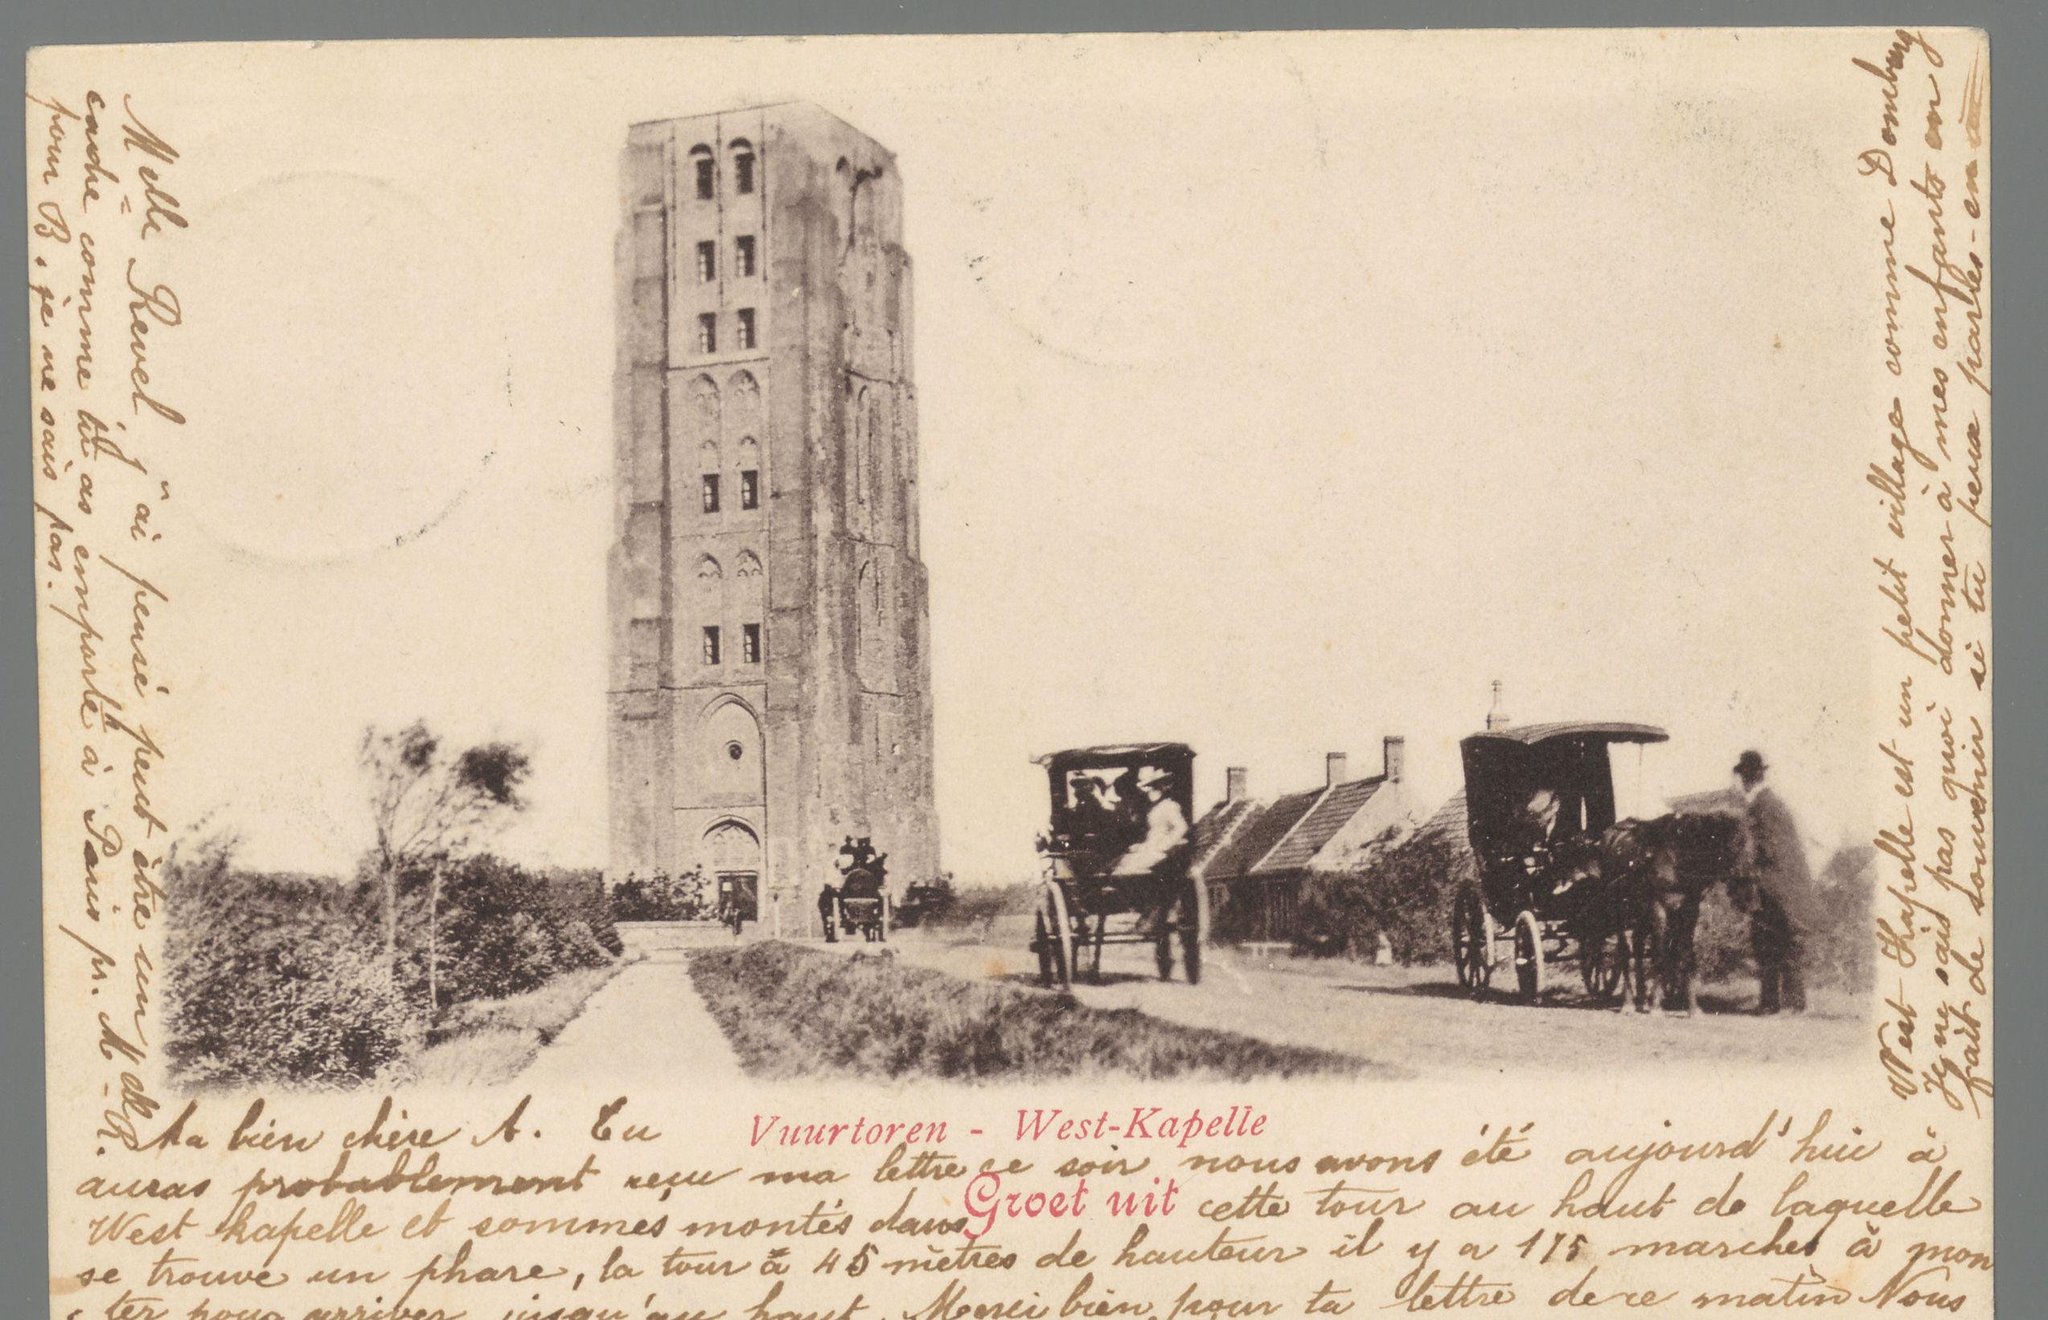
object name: photomechanical print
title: Vuurtoren - West-Kapelle. Groet uit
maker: Anonymous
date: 1892-1902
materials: cardboard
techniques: photograph, writing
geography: westkapelle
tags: lighthouse, lightship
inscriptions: postage stamp